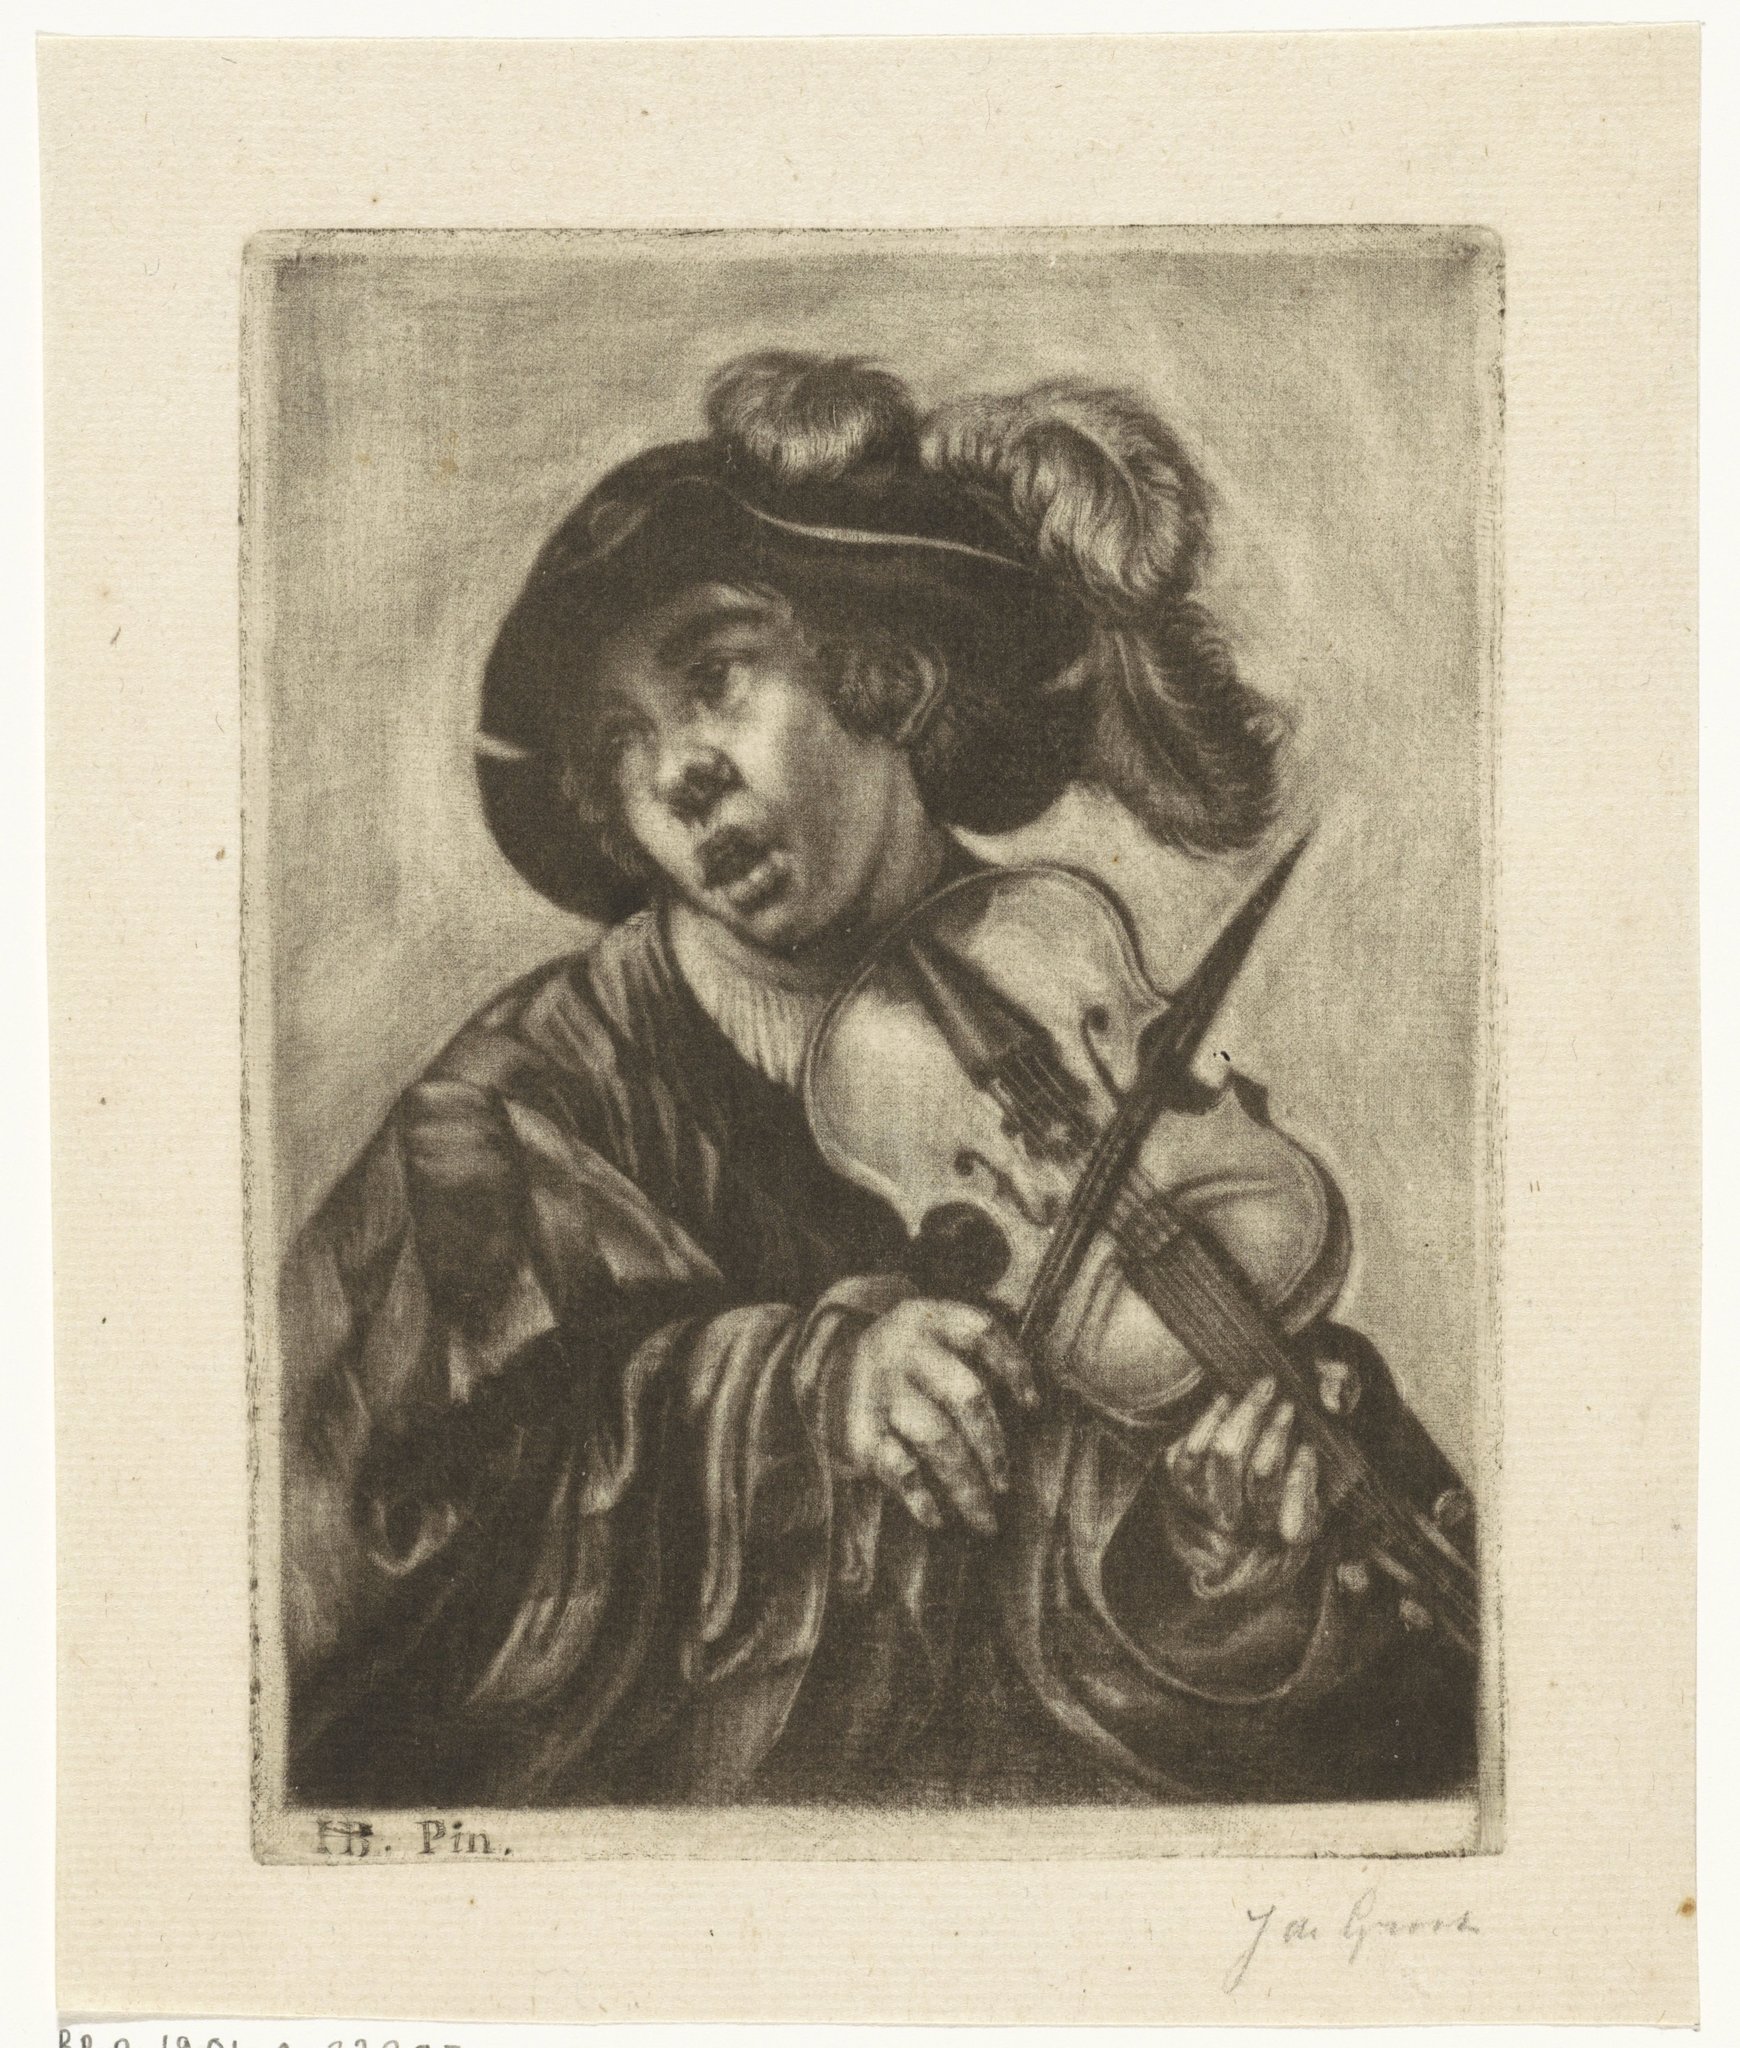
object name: print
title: Portret van Daniel Boon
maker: johannes de groot (ii)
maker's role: painter, print maker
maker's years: 1688-1796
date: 1718-1776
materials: paper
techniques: engraving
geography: northern netherlands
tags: one person playing string instrument (bowed), historical persons, portrait of a musician, portrait of composer, portrait, self-portrait of painter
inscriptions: collector's mark: Lugt 2228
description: De schilder en musicus Daniel Boon als violist. Hij draagt een hoed met veren.